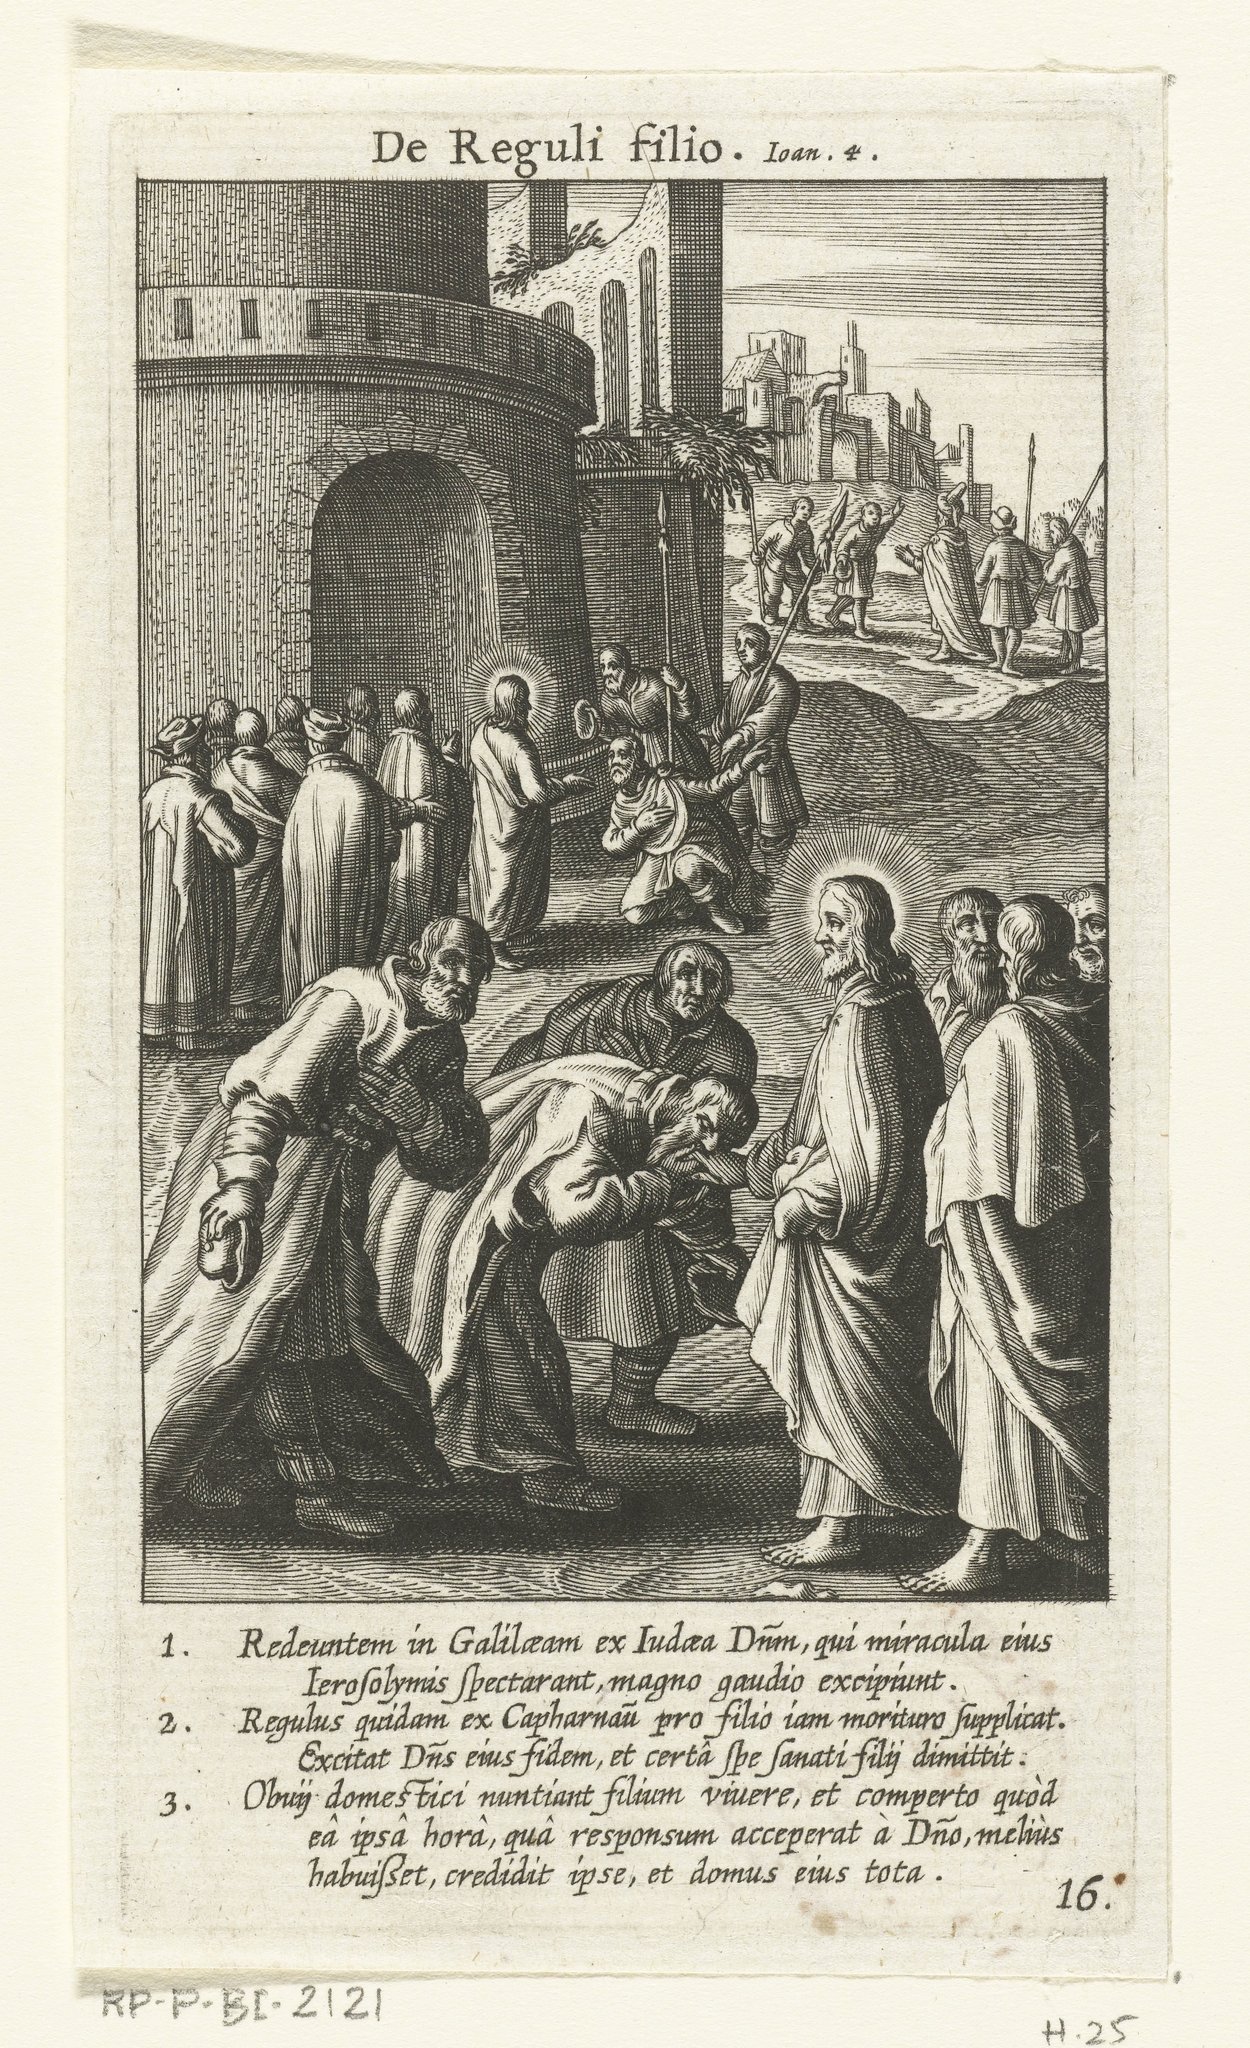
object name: book illustration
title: Vitae passionis et mortis Jesu Christ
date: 1590-1622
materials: paper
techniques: engraving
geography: antwerp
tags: the centurion of capernaum, kneeling before christ, begs him to heal his paralytic servant (or son) (matthew 8:5-13; luke 7:1-10; john 4:46-54)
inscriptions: collector's mark: Lugt 240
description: Prent uit: Joannes Bourgois, Vitae passionis et mortis Jesu Christi Somini nostri mysteria, Antwerpen Hendrick Aertssens, 1622, afb. 16